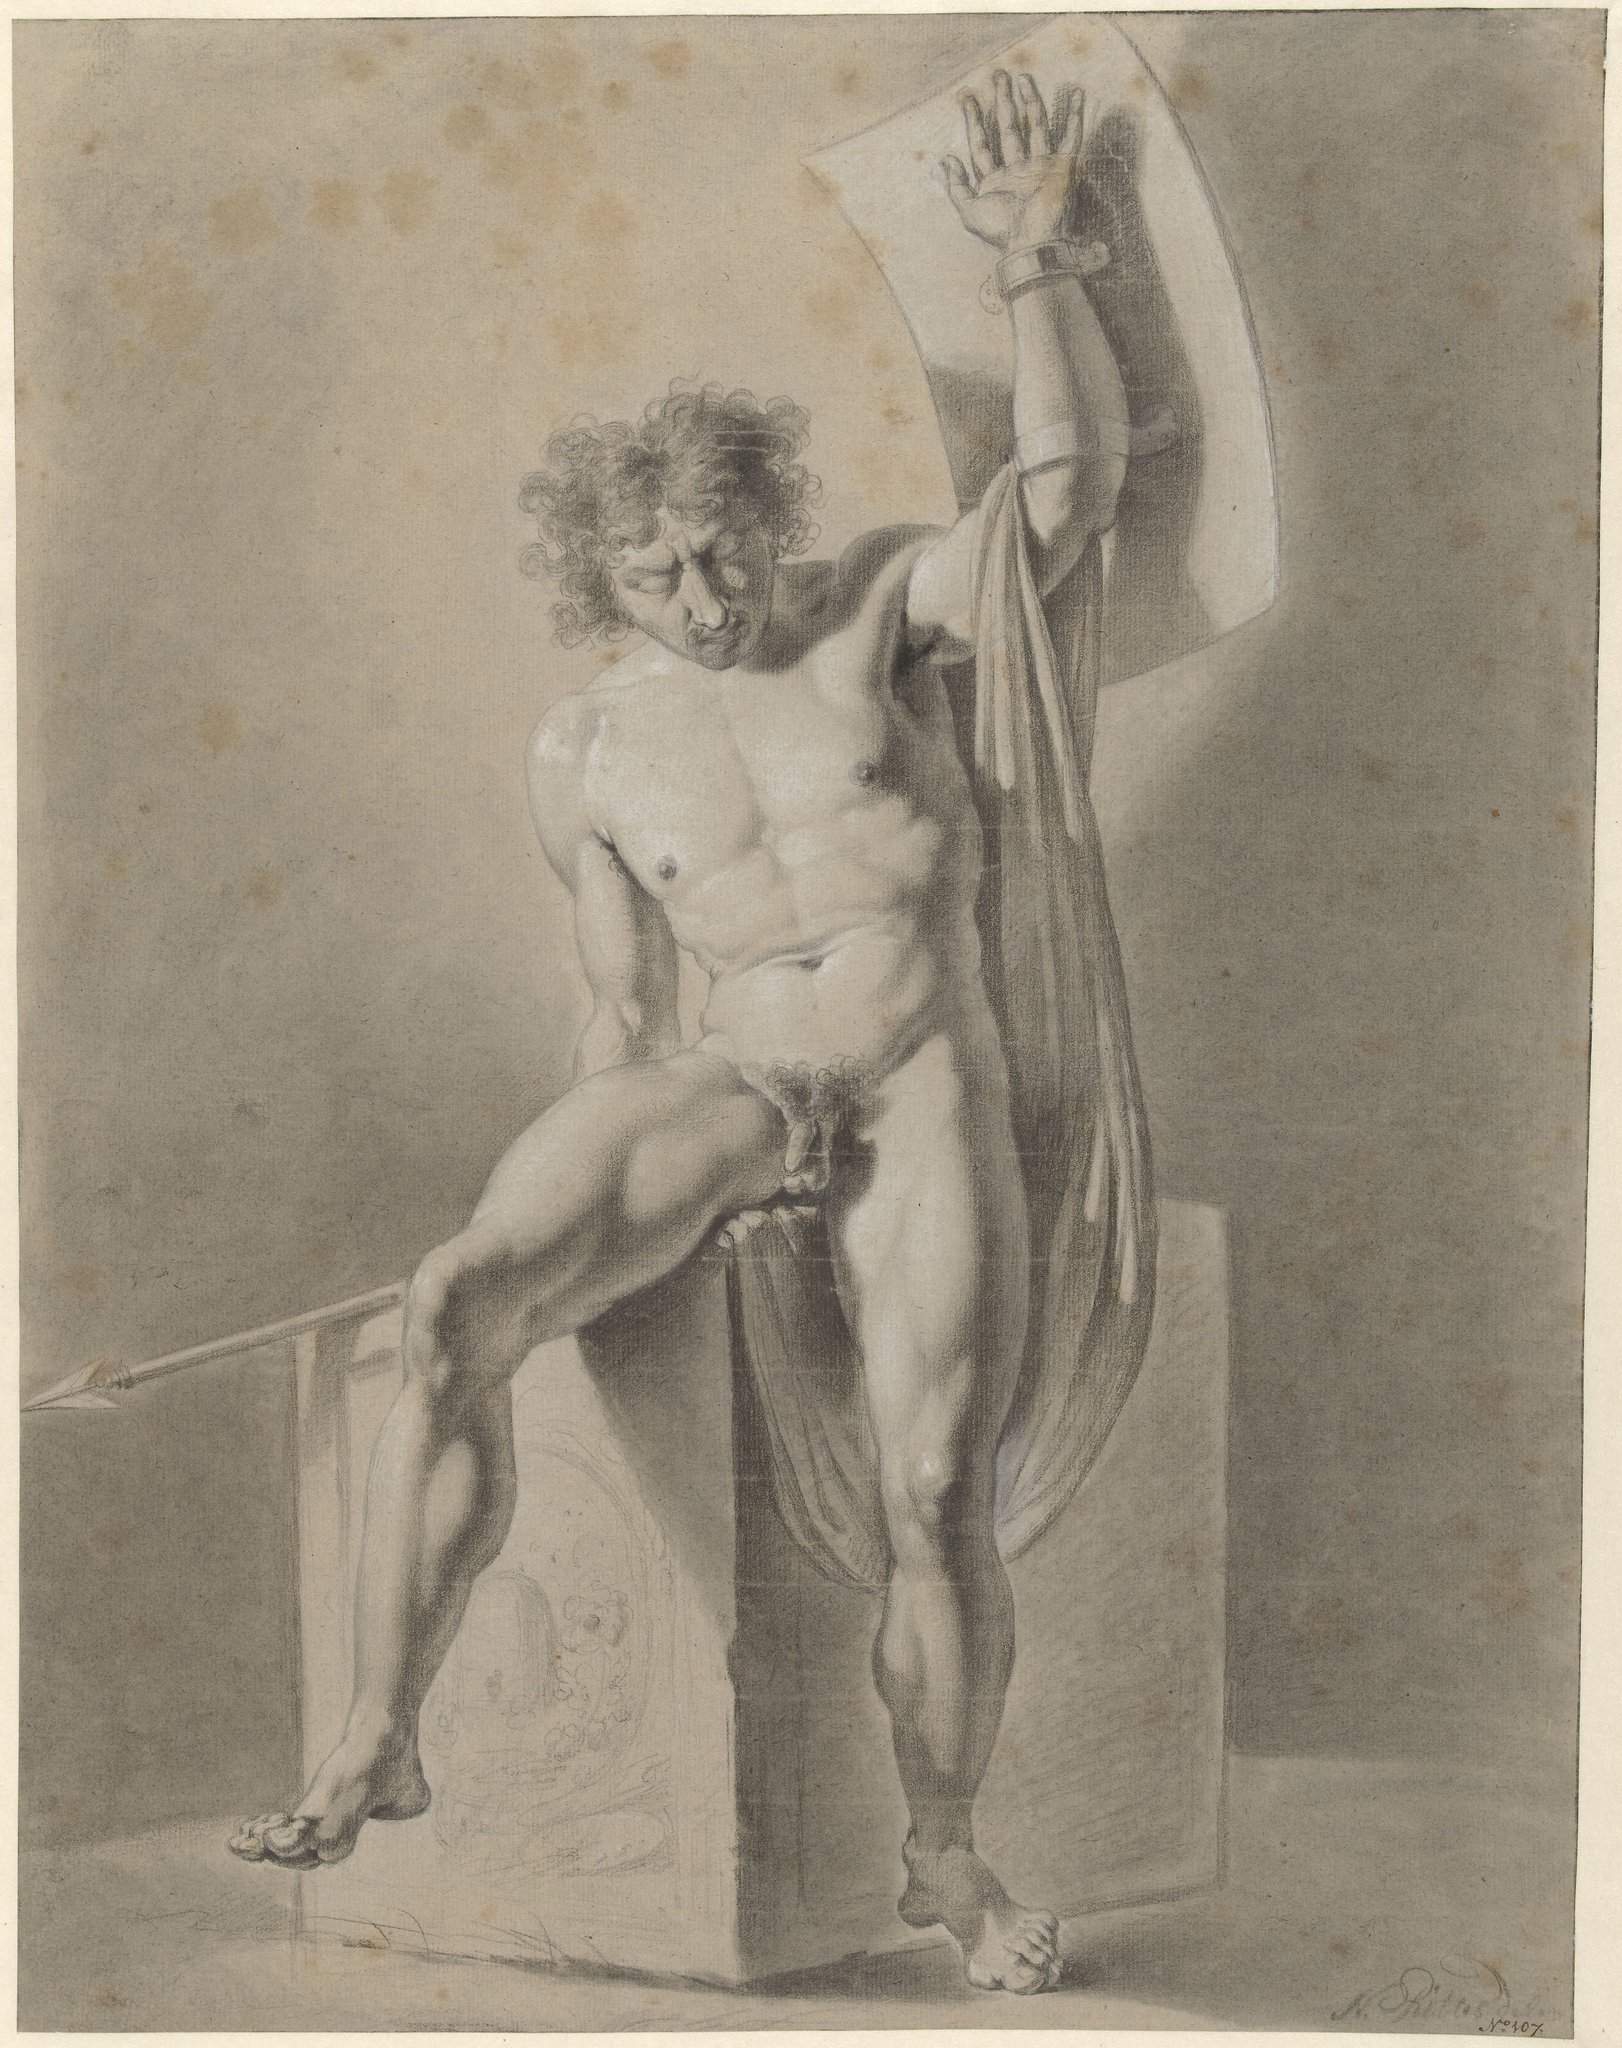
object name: drawing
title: Mannelijk naakt, zittend op een blok, met speer en schild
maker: george nikolaus ritter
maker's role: draughtsman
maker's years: 1749-1809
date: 1759-1809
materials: chalk, paper